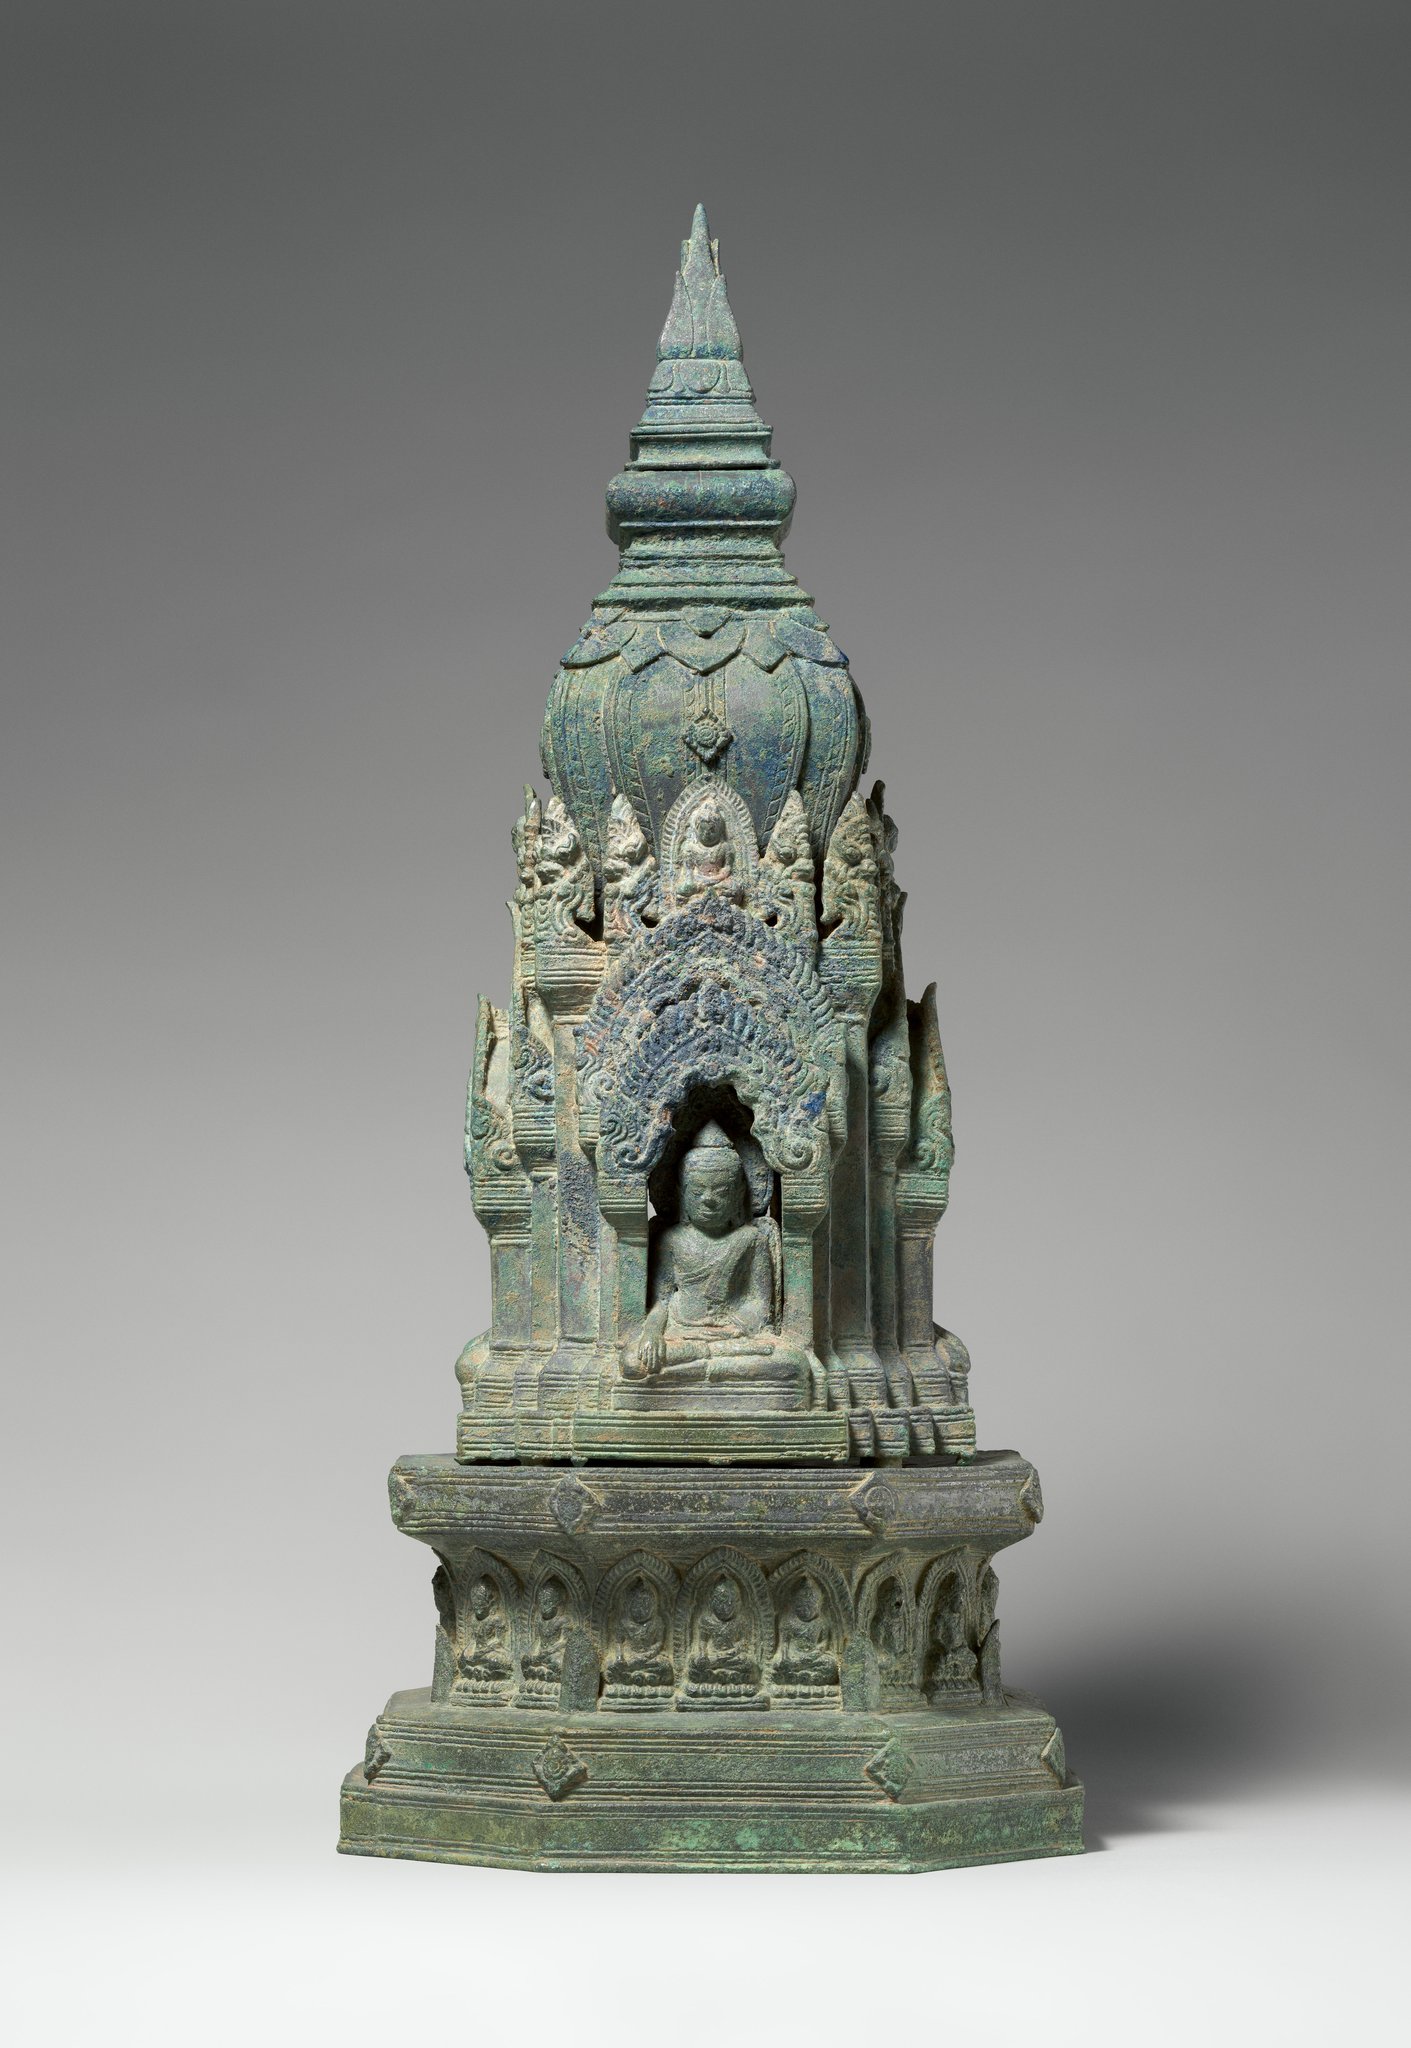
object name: shrine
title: Buddhist Shrine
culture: thai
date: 1201-1300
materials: bronze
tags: buddha